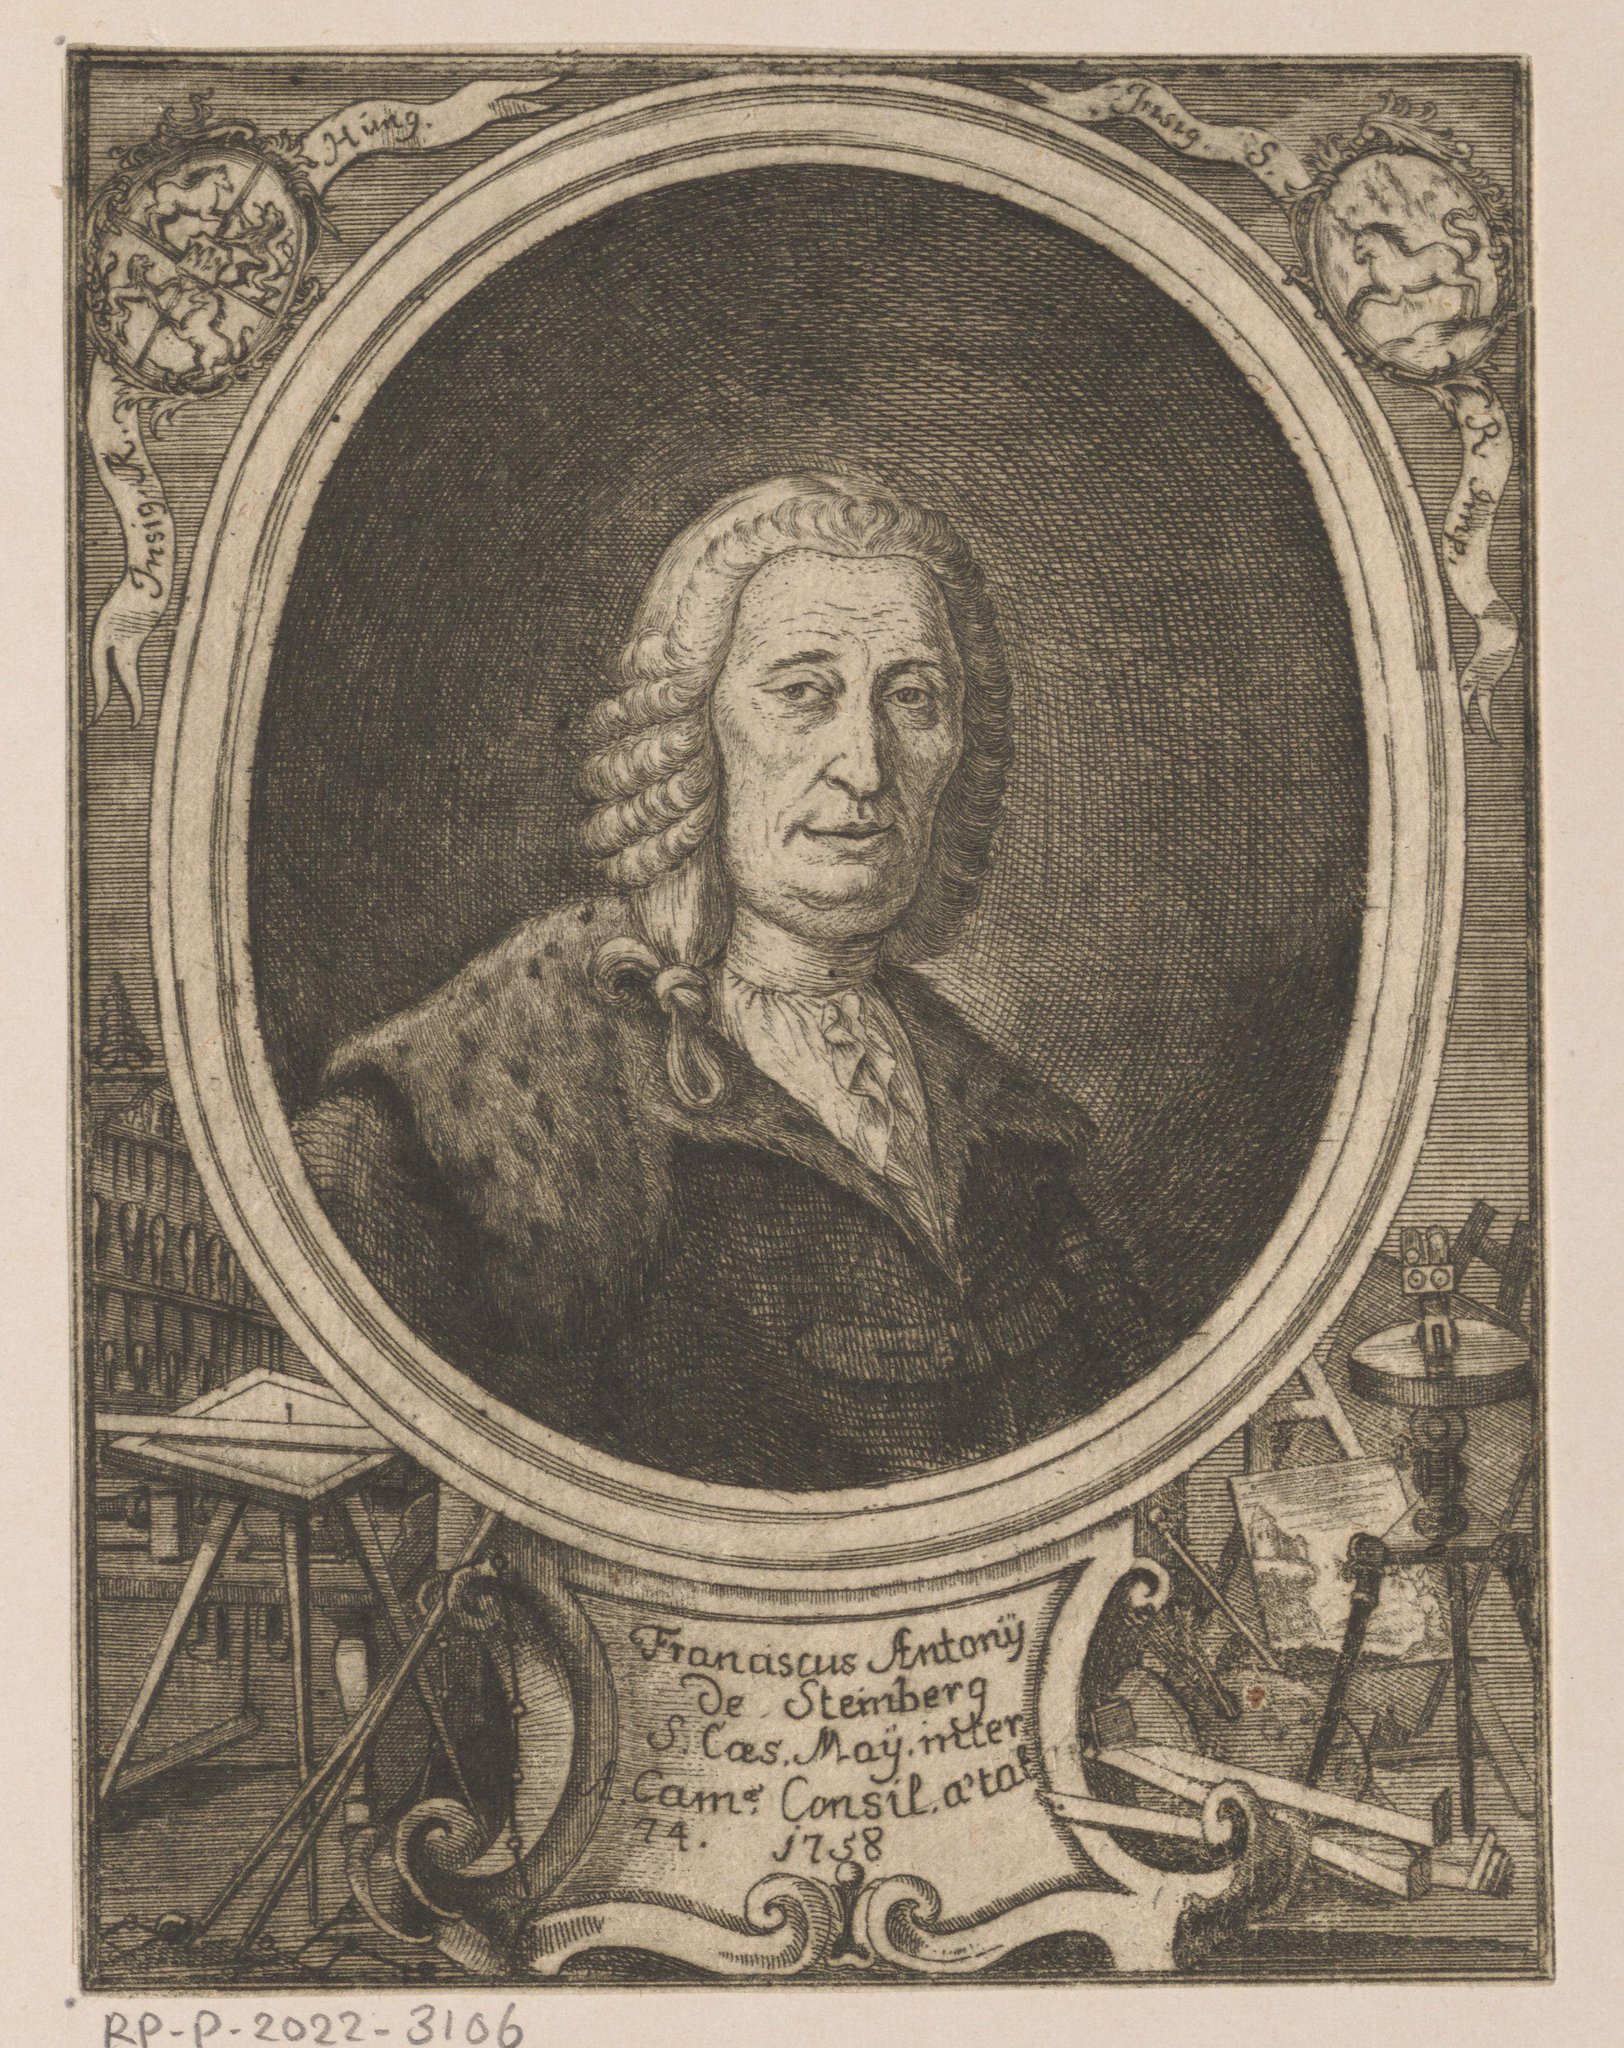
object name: print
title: Portret van Franz Anton von Steinberg op 74-jarige leeftijd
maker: Anonymous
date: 1758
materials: paper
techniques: drypoint, etching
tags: painter, historical persons, portrait, self-portrait of artist, geography (+ portrait of scholar, scientist)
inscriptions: inscription: ‘[...]ce de ar[...] o Su[...]’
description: Prent waarschijnlijk uit: Steinberg, Franz Anton von. Gründliche Nachricht von dem in dem Inner-Krain, gelegenen Czirknitzer See. S.l.: Anna Elisabetha Reichhardtin, 1758.